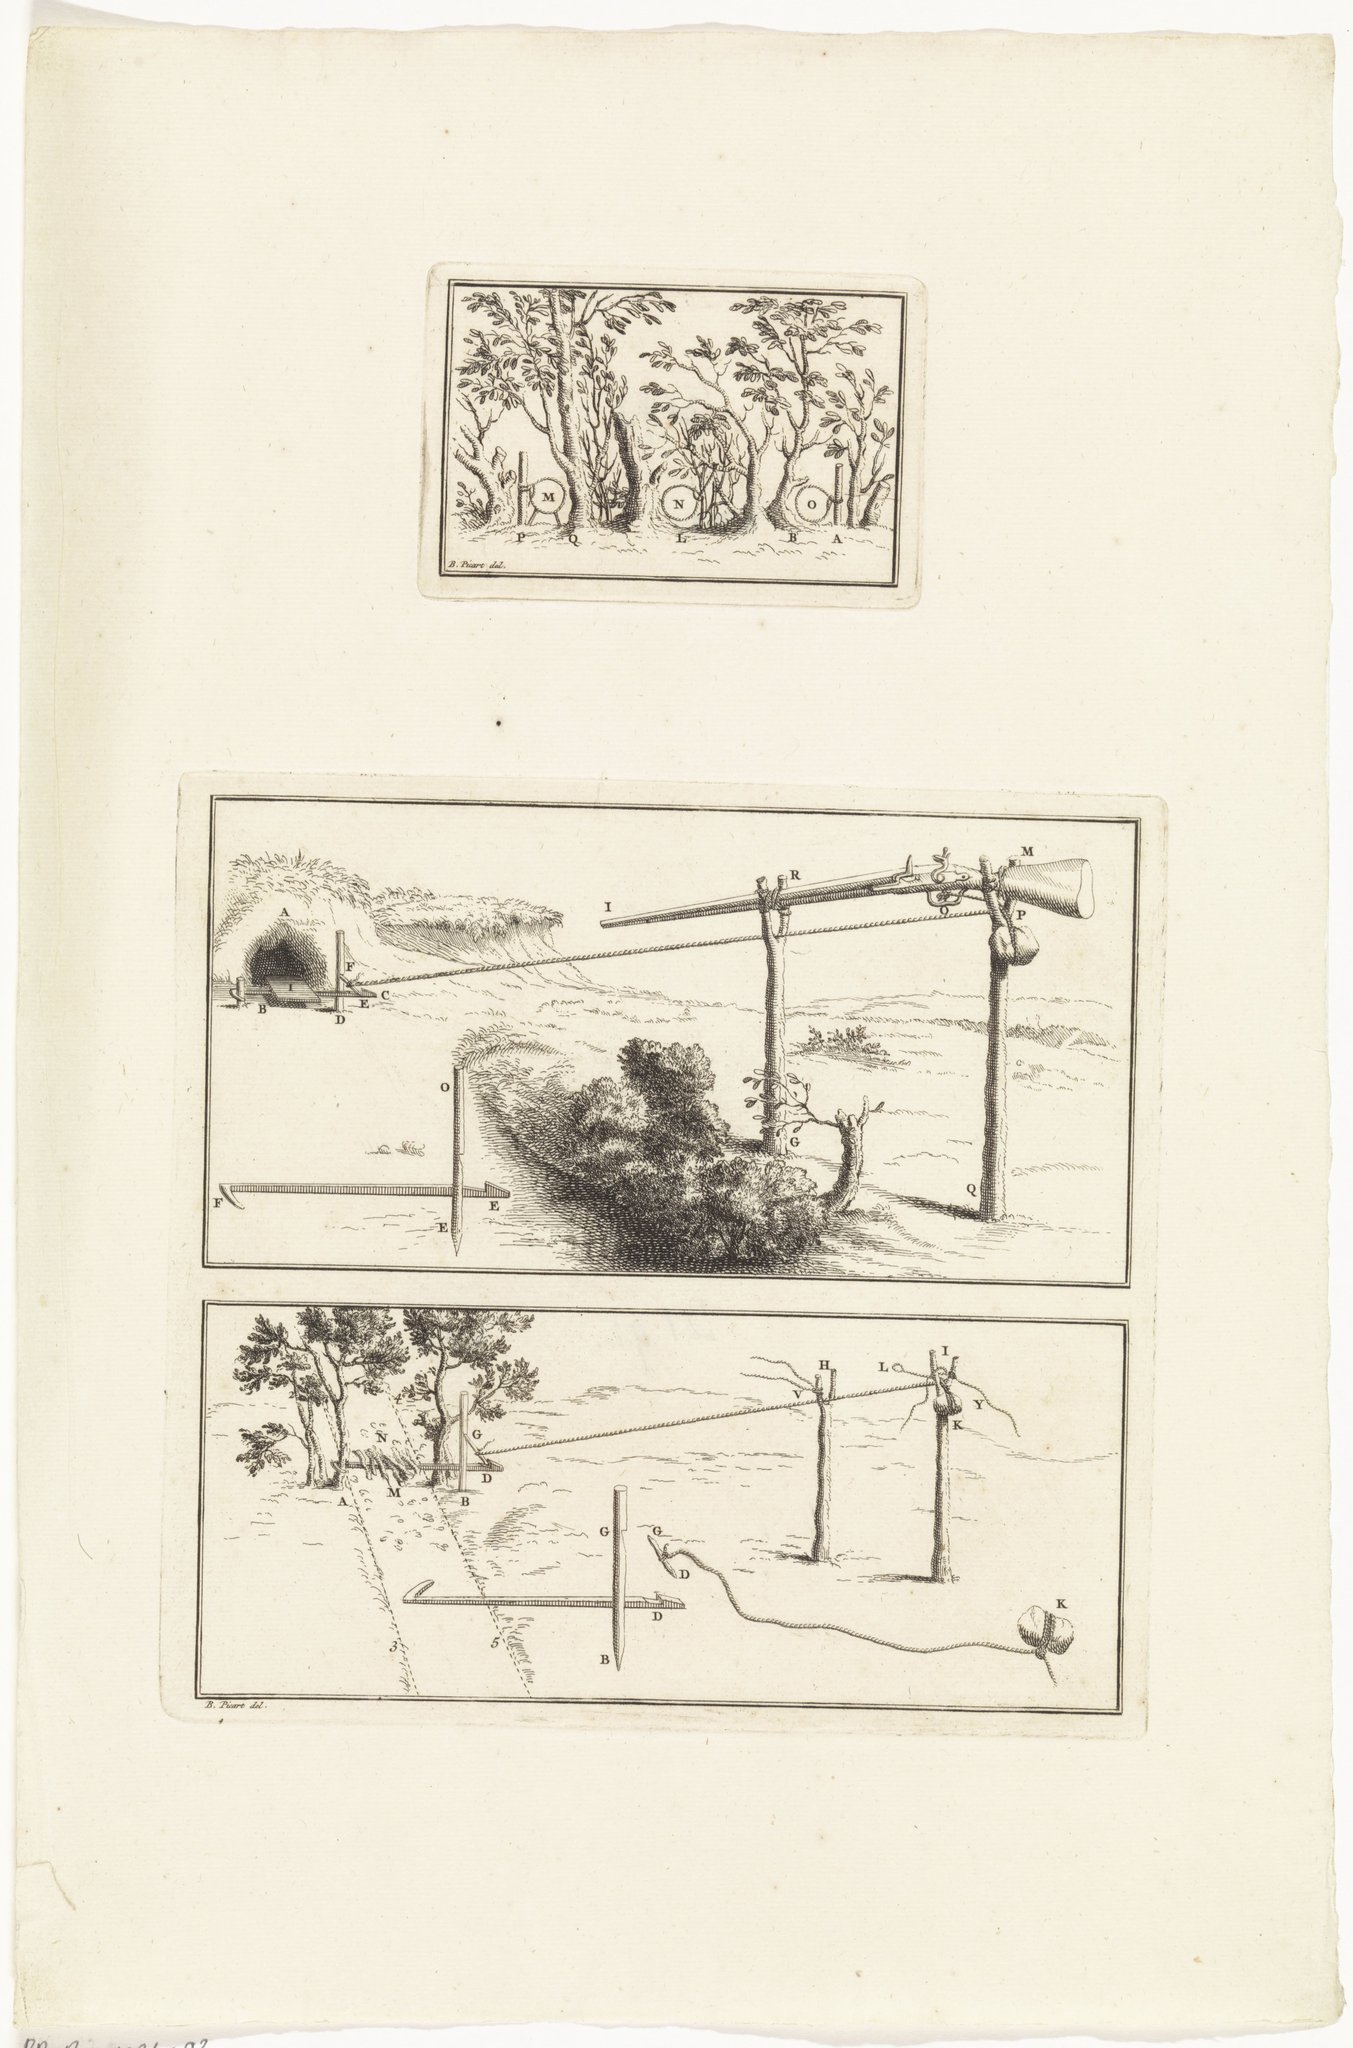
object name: print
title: Dierenvallen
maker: bernard picart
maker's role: draughtsman, print maker, publisher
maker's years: 1673-1733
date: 1683-1733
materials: paper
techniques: etching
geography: amsterdam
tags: catching animals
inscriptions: collector's mark: Lugt 2233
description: Prenten bedoeld voor: Chomel, Noel. Dictionnaire oeconomique, contenant divers moïens d'augmenter son bien, et de conserver sa santé. Amsterdam: Johannes Covens en Cornelis Mortier, 1732.